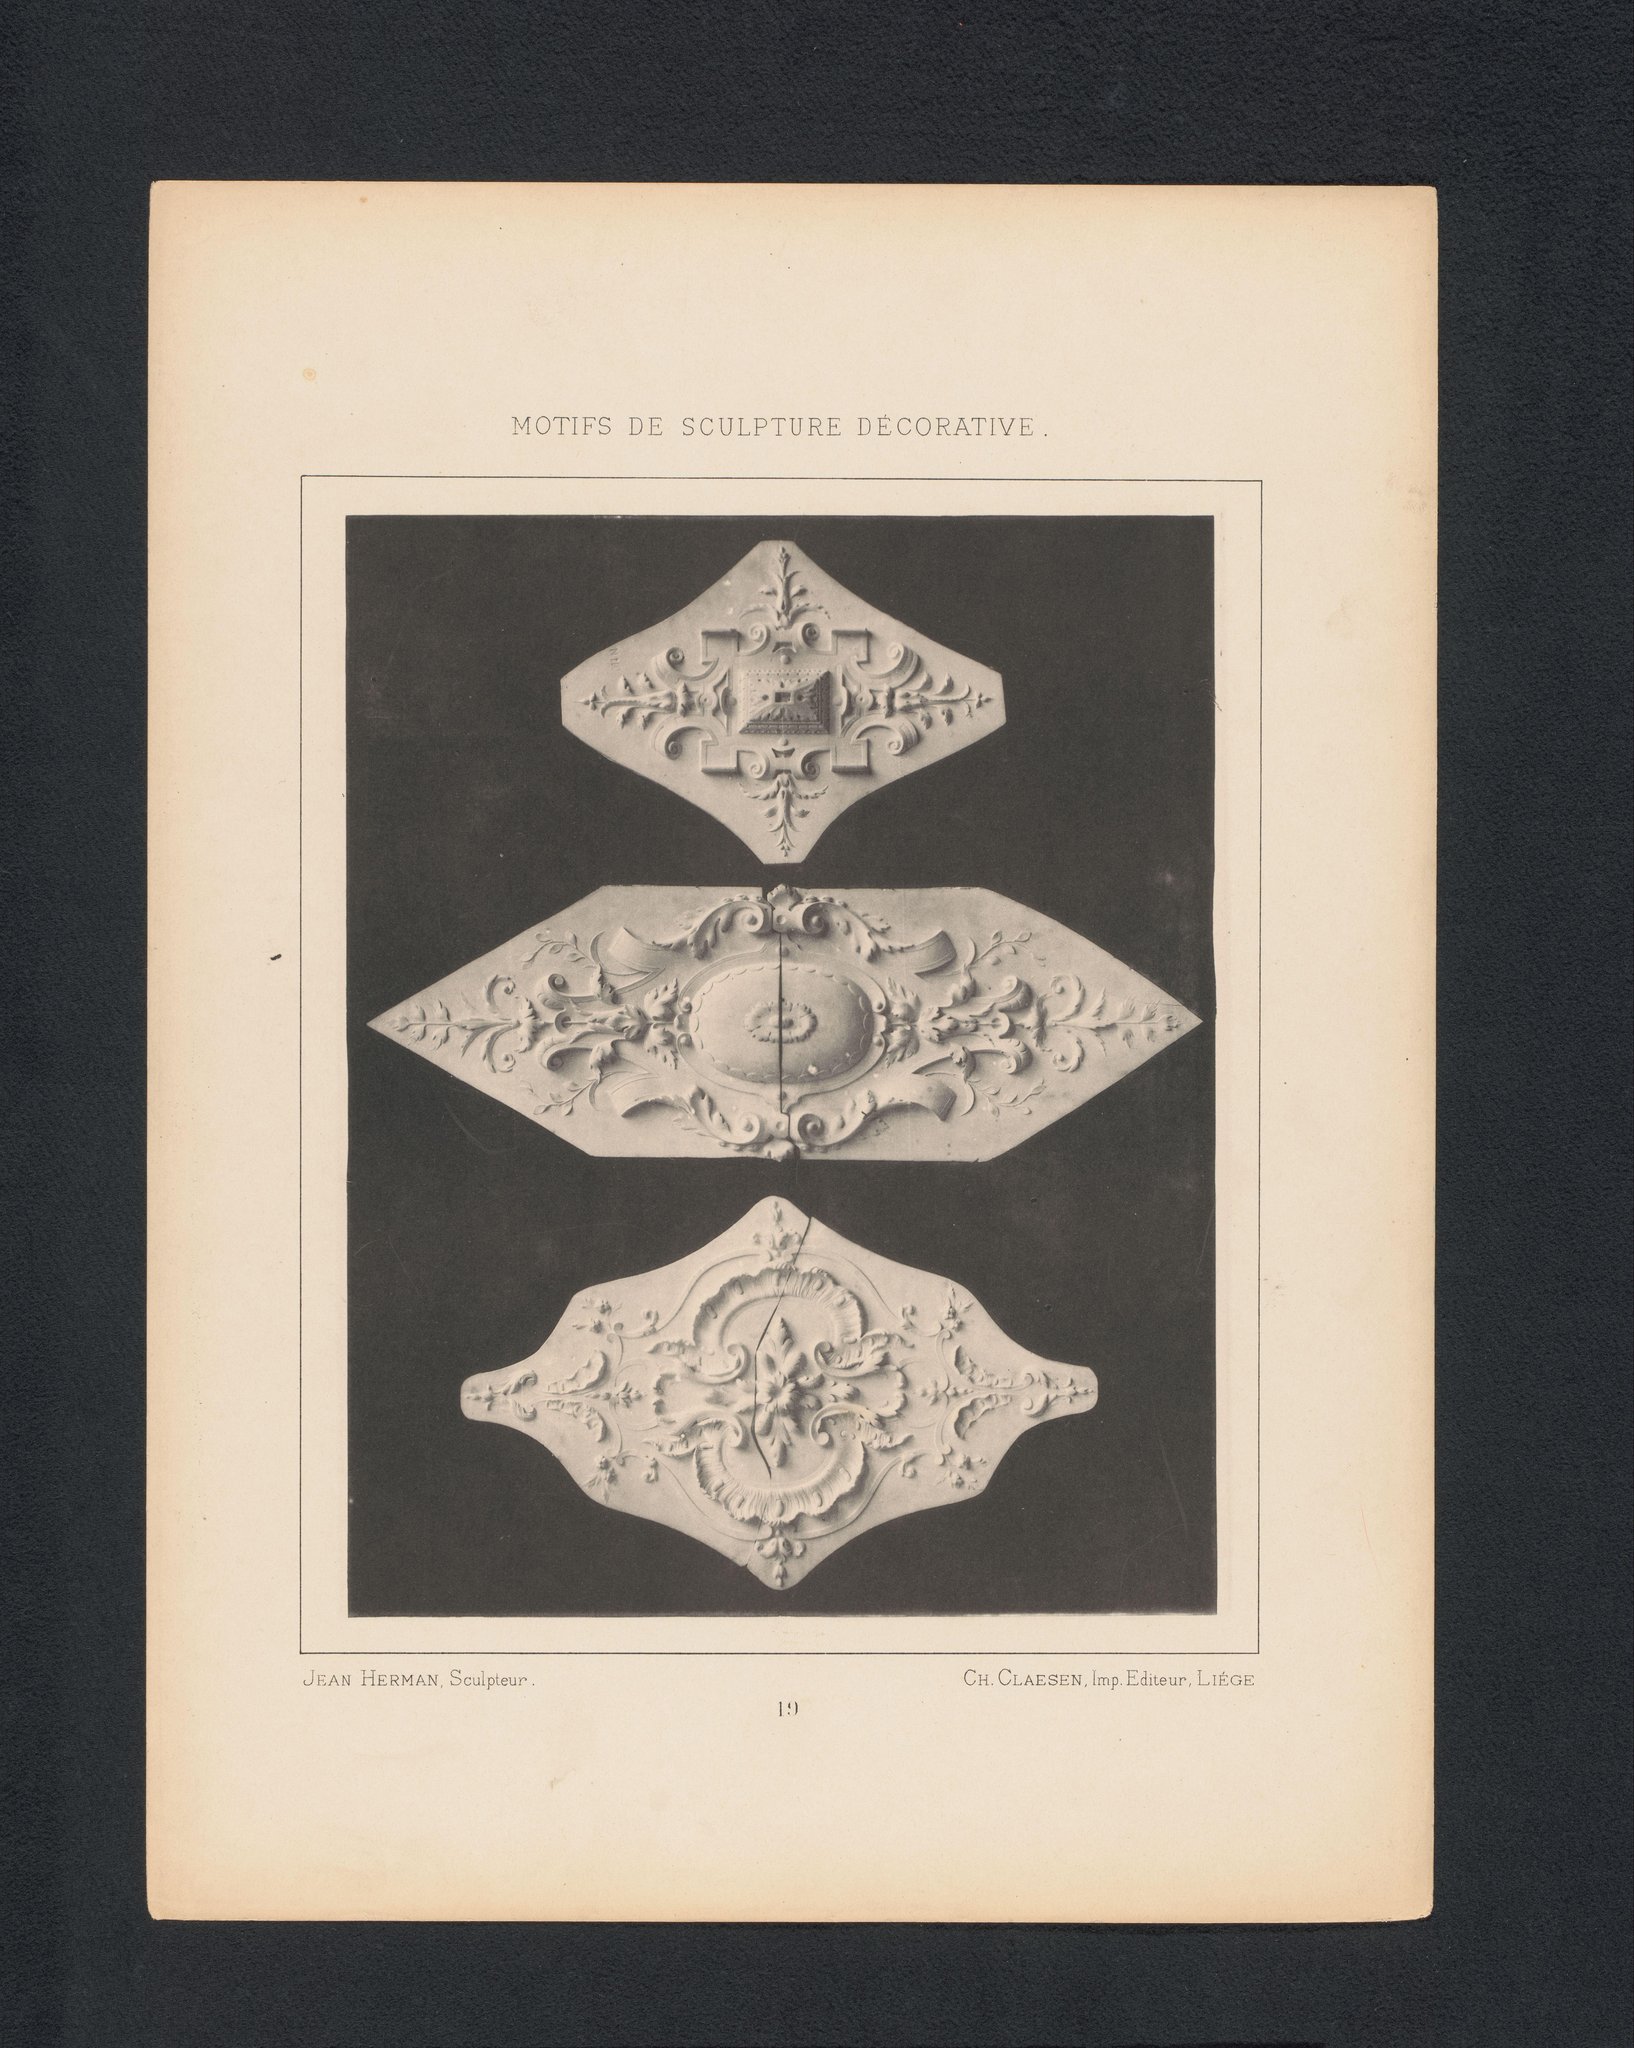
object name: photomechanical print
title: Drie reliëfs met bladranken, gebeeldhouwd door Jean Herman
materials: paper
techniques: photograph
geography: liège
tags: foliage, tendrils, branches ~ ornament, sculpture (+ relief ~ sculpture)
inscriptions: number: ‘19’, inscription: ‘Jean Herman, Sculpteur.’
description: Deze prent maakt deel uit van een omslag met 28 prenten en een titelblad.